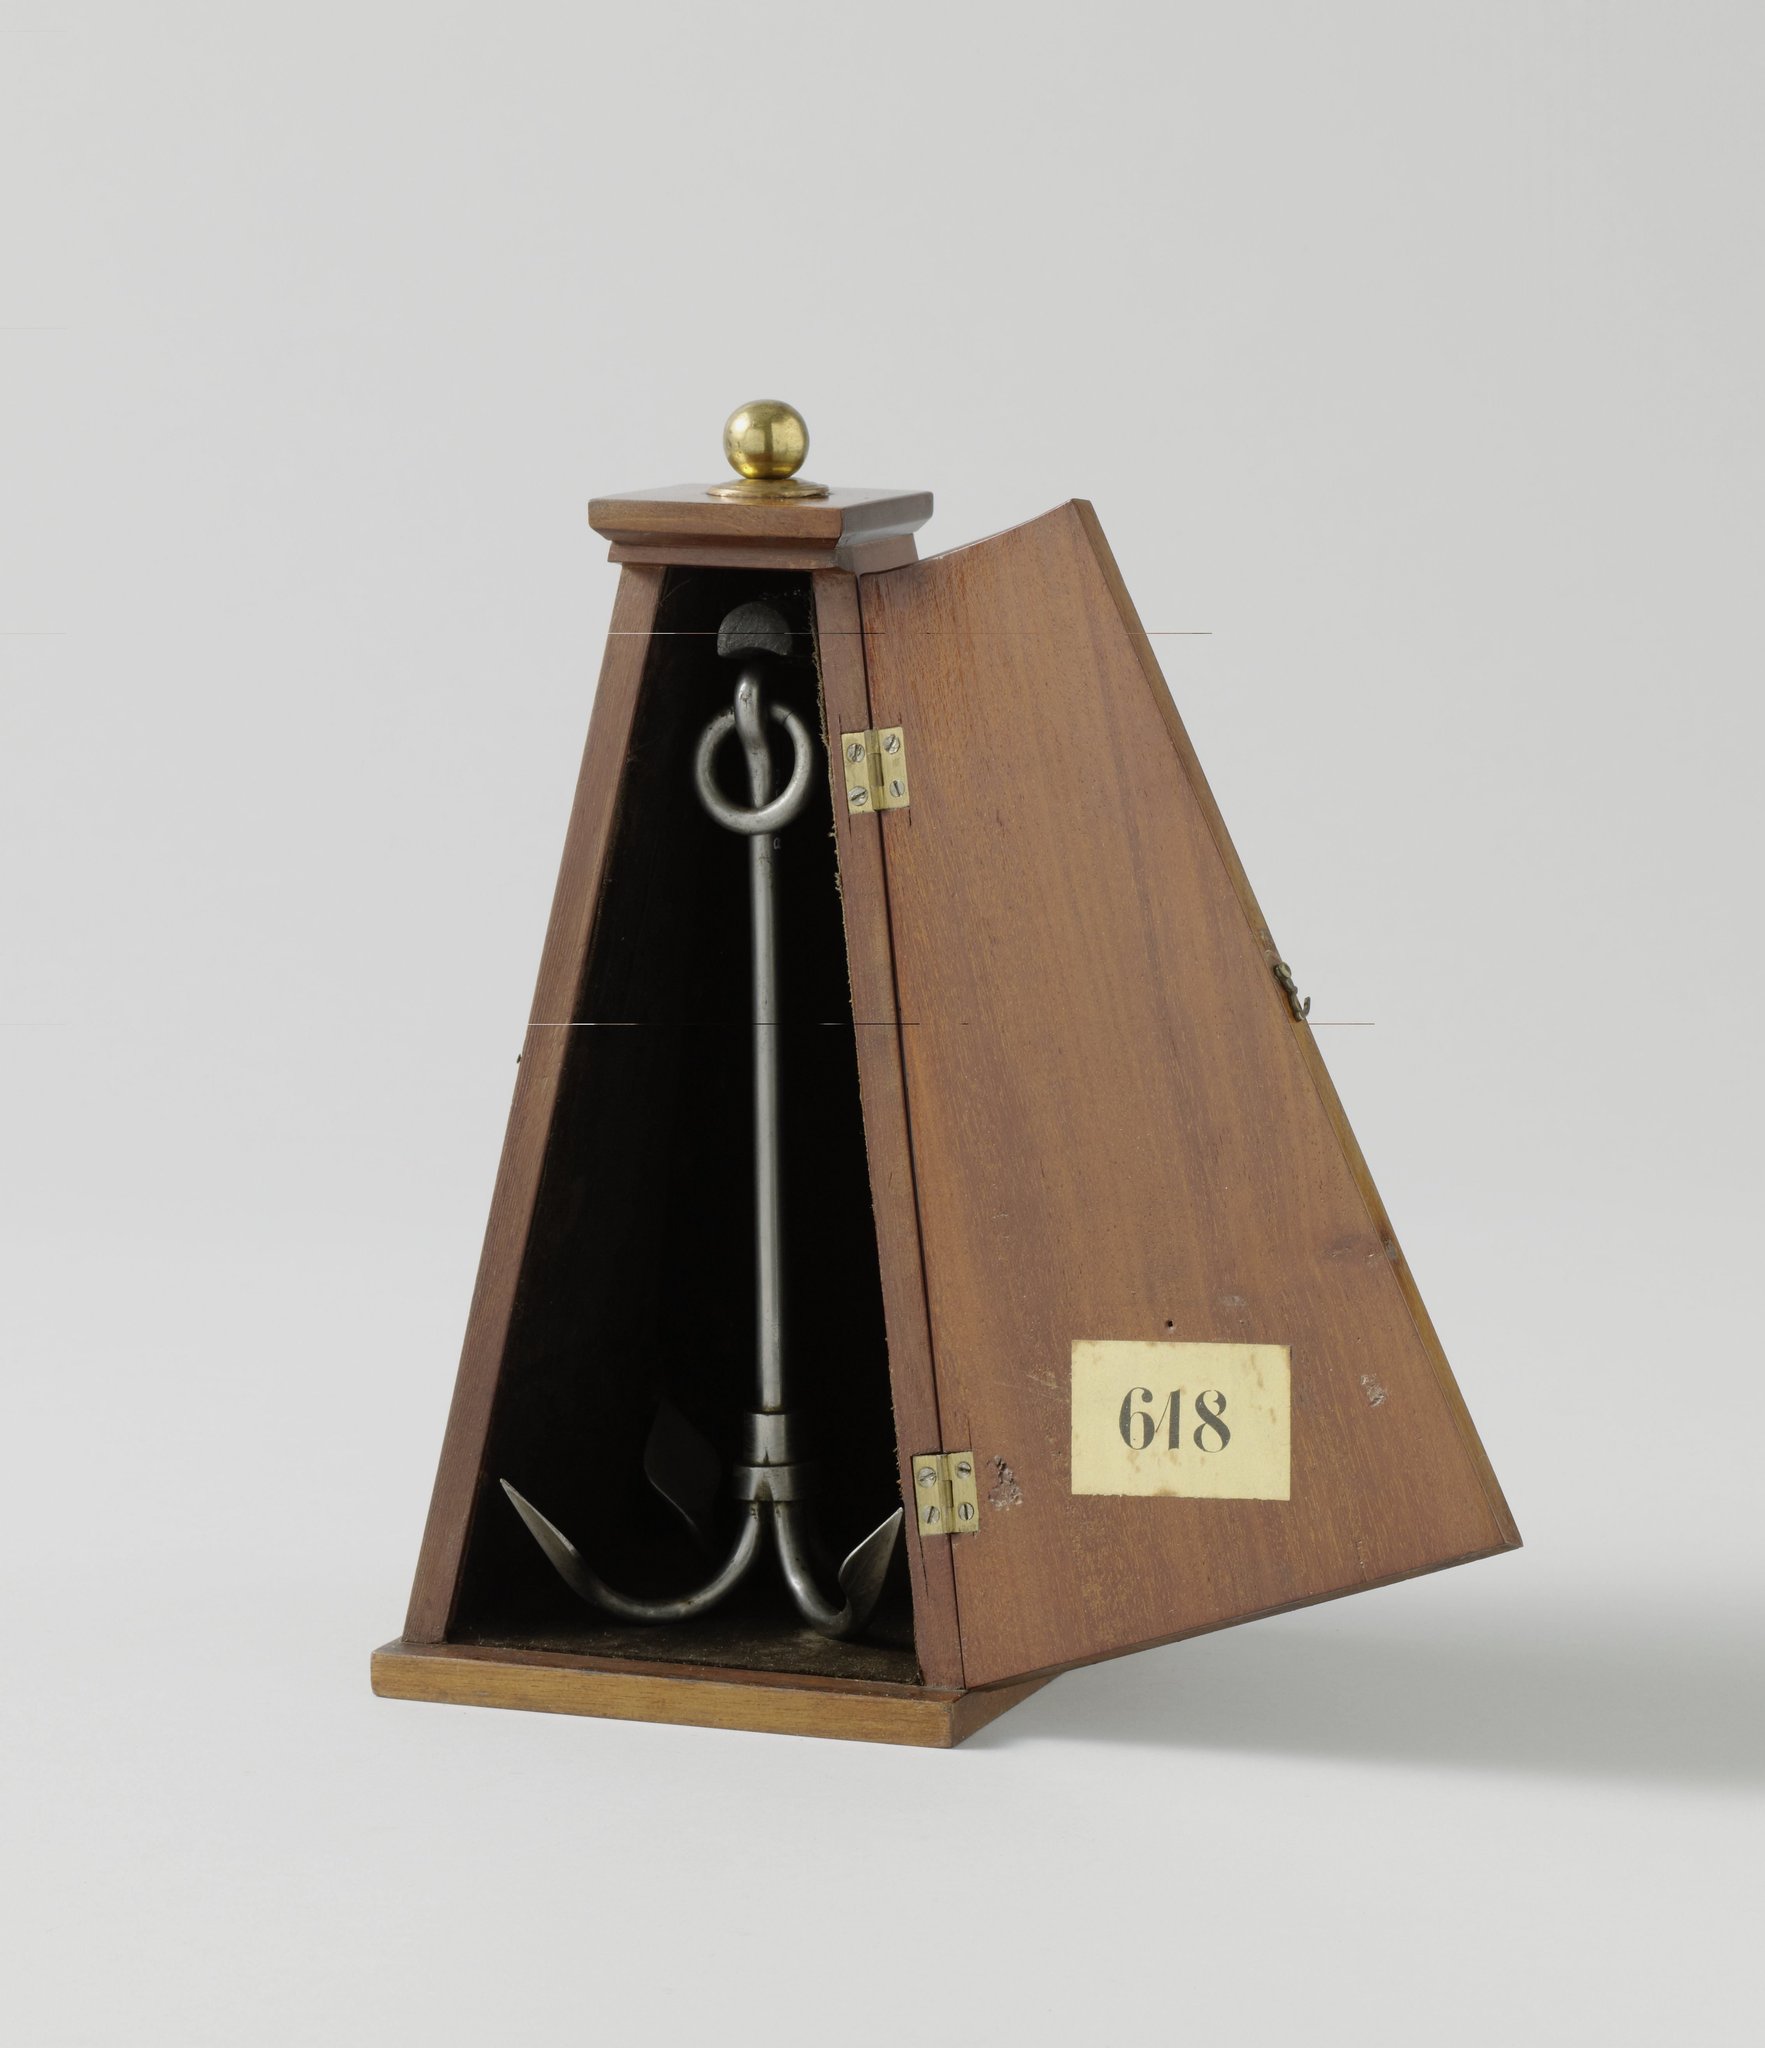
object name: presentation model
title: Model of a Grapnel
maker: Anonymous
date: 1800-1850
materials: brass, textile, iron, wood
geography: netherlands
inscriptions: label, on the door: ‘618’ former inventory label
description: Model van een vierarmige dreg in een houten kistje, gevoerd met zwart laken en versierd met een messing bal bovenop. De dreg heeft een ring aan de top van de schacht; de schacht is verstevigd bij de kroon.